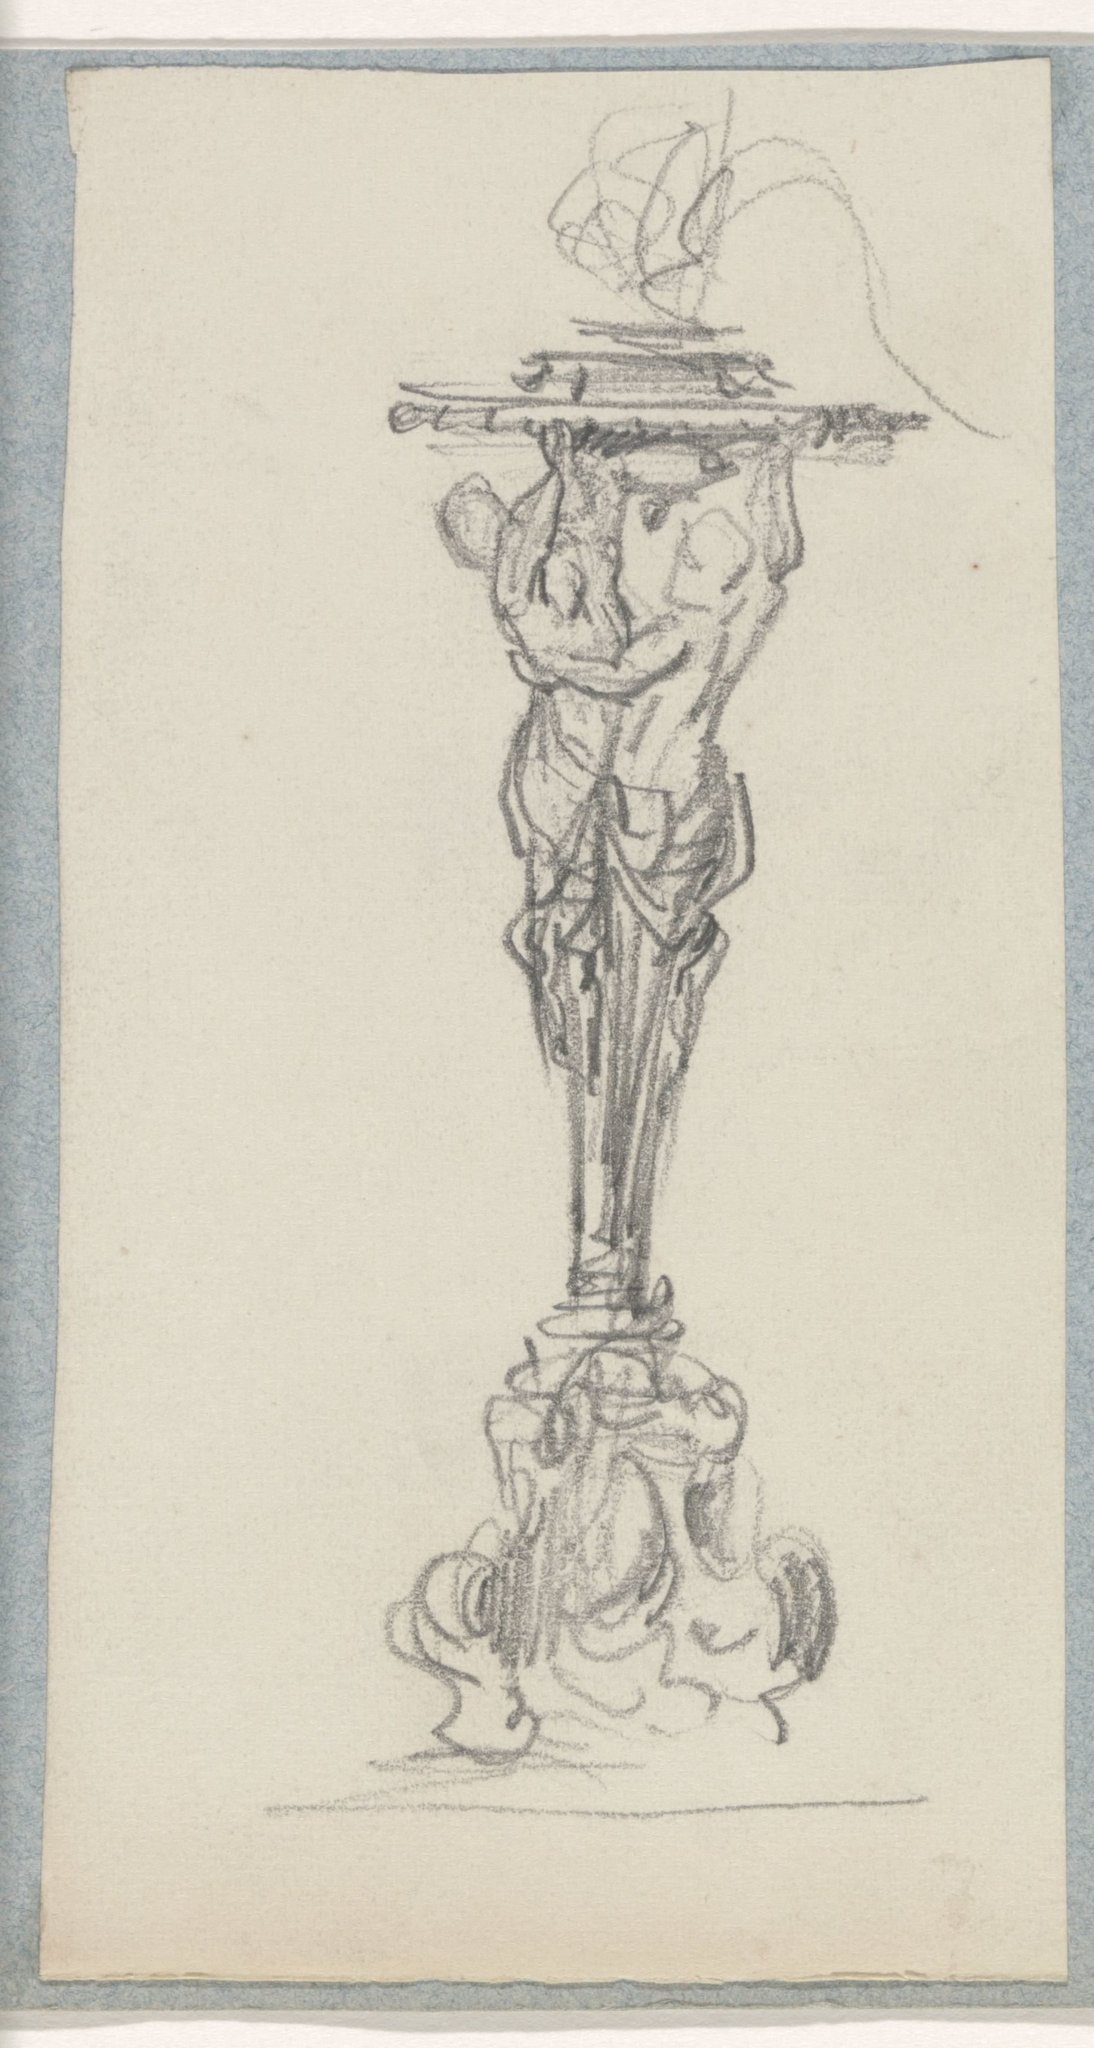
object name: design drawing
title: Ontwerp voor torchère met hermfiguren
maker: henri cameré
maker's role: designer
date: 1864-1894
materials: paper, pencil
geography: paris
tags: torch, candlestick